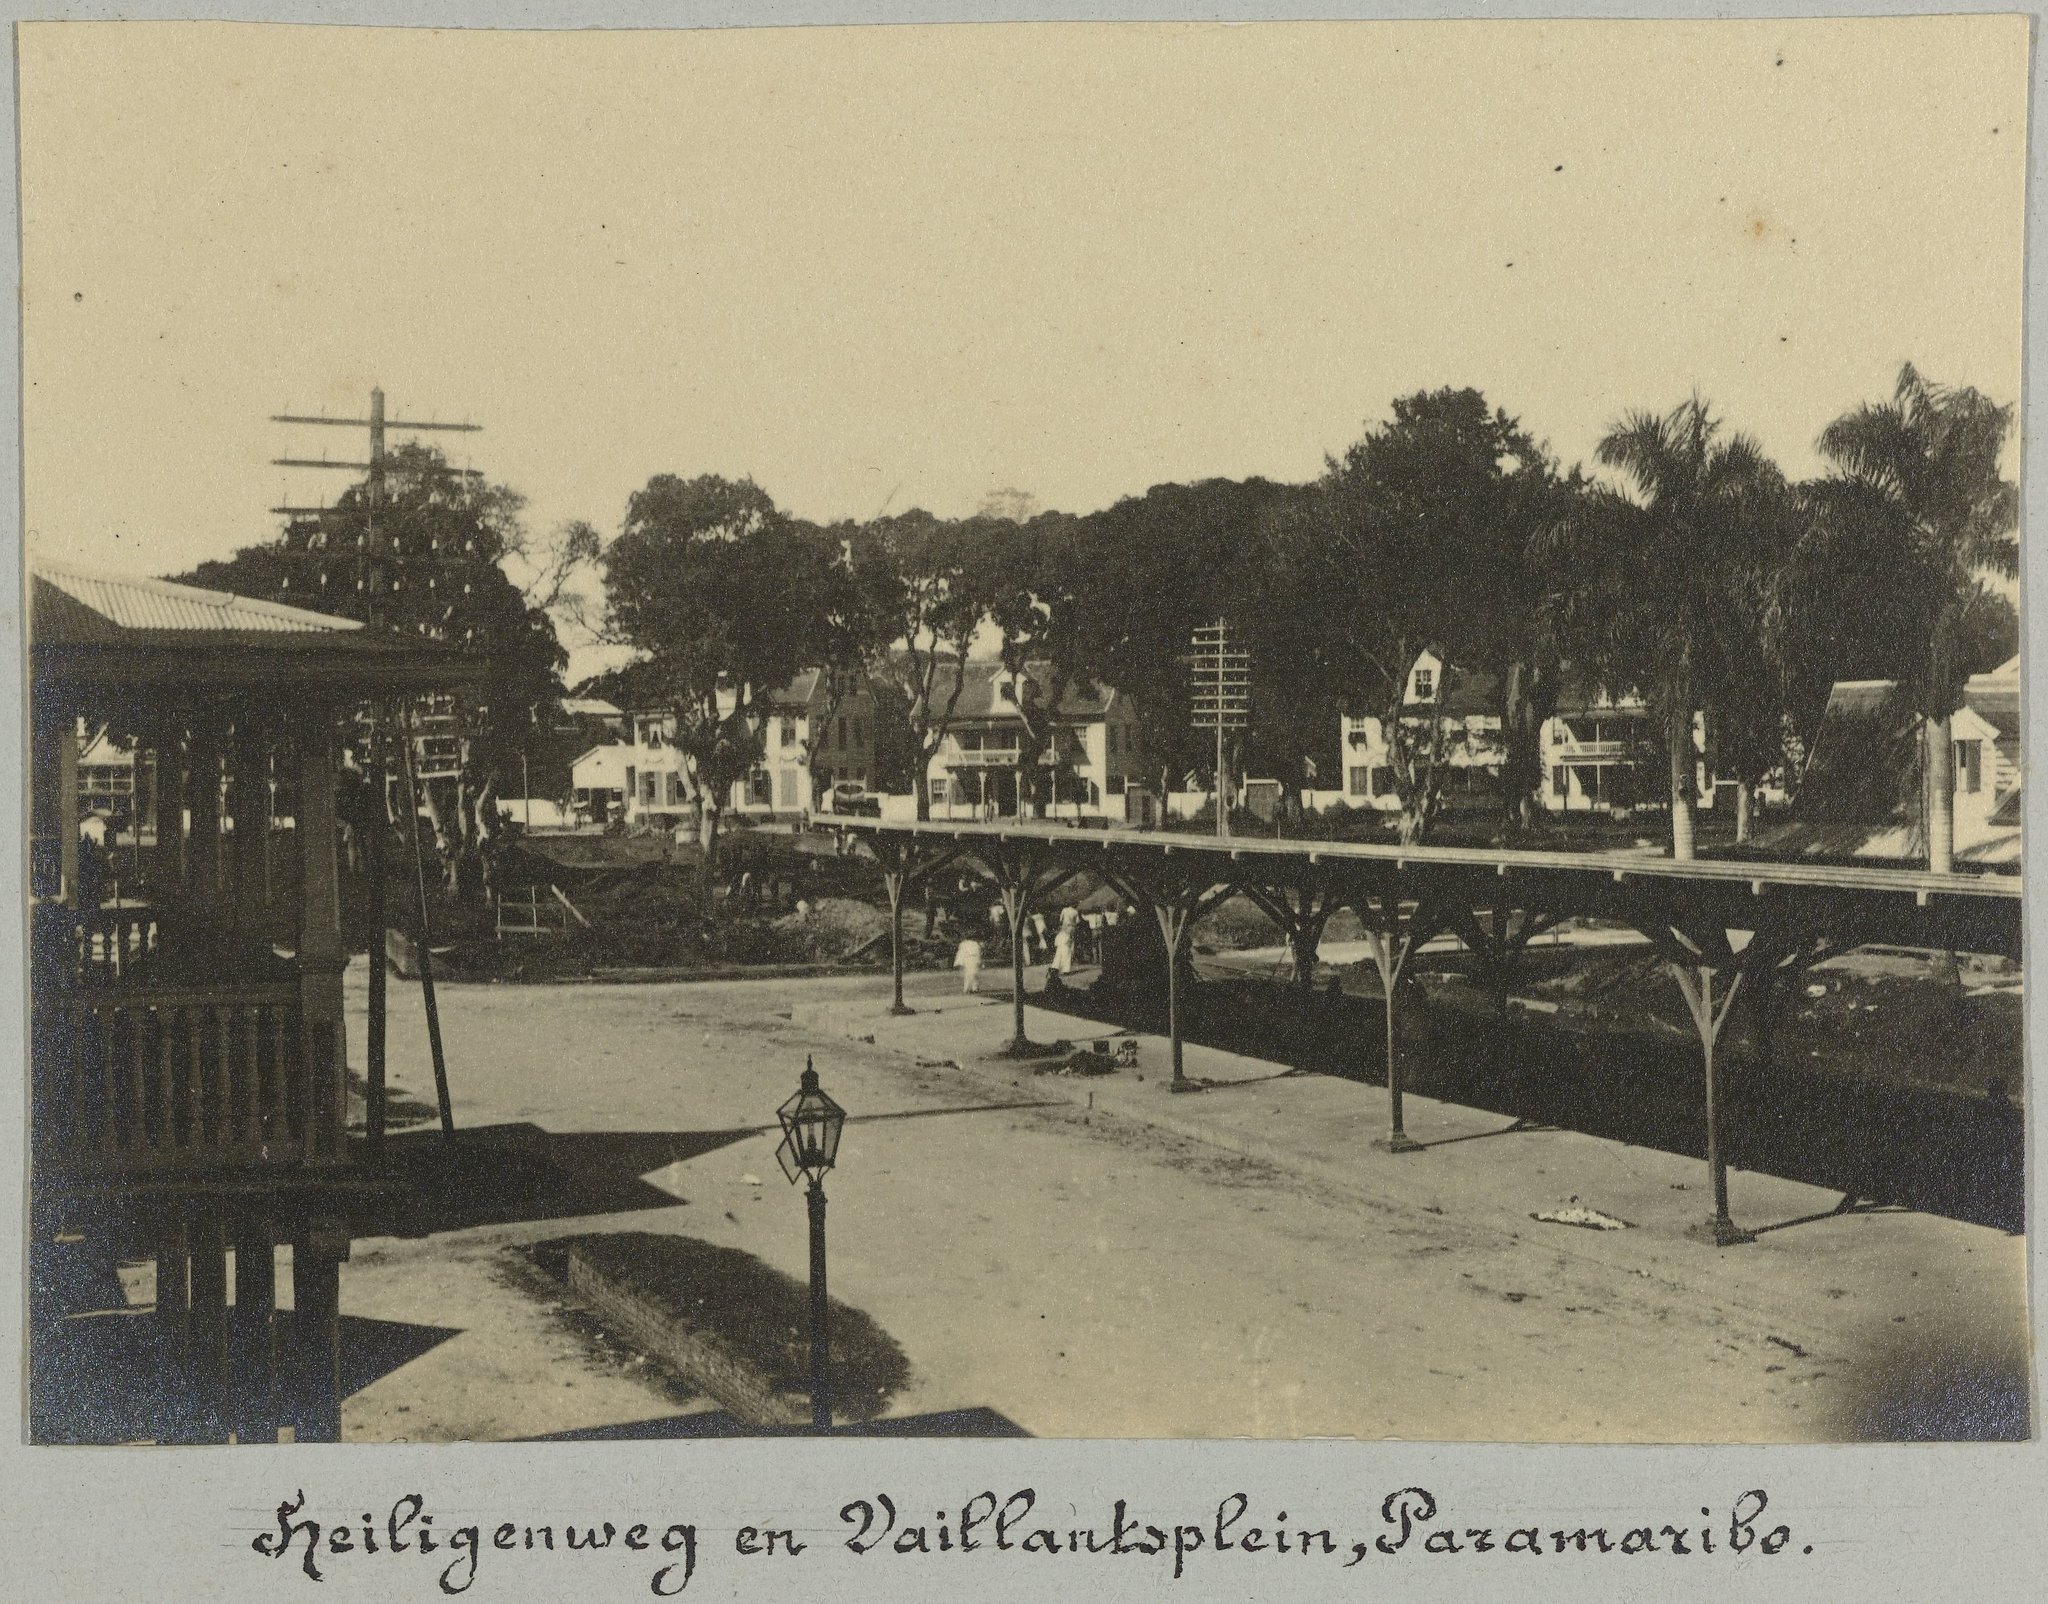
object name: photograph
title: Heiligenweg en Vaillantsplein, Paramaribo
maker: hendrik doijer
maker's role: engineer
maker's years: 1863-1925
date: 1903-1910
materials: photographic support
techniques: gelatin silver print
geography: suriname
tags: suriname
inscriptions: inscription: ‘7. / Heiligenweg en Vaillantsplein, Paramaribo.’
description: Gezicht op de Heiligenweg met overdekte passage en het Vaillantsplein te Paramaribo. Onderdeel van het fotoalbum Souvenir de Voyage (deel 1), over het leven van de familie Doijer in en rond de plantage Ma Retraite in Suriname in de jaren 1903-1910.